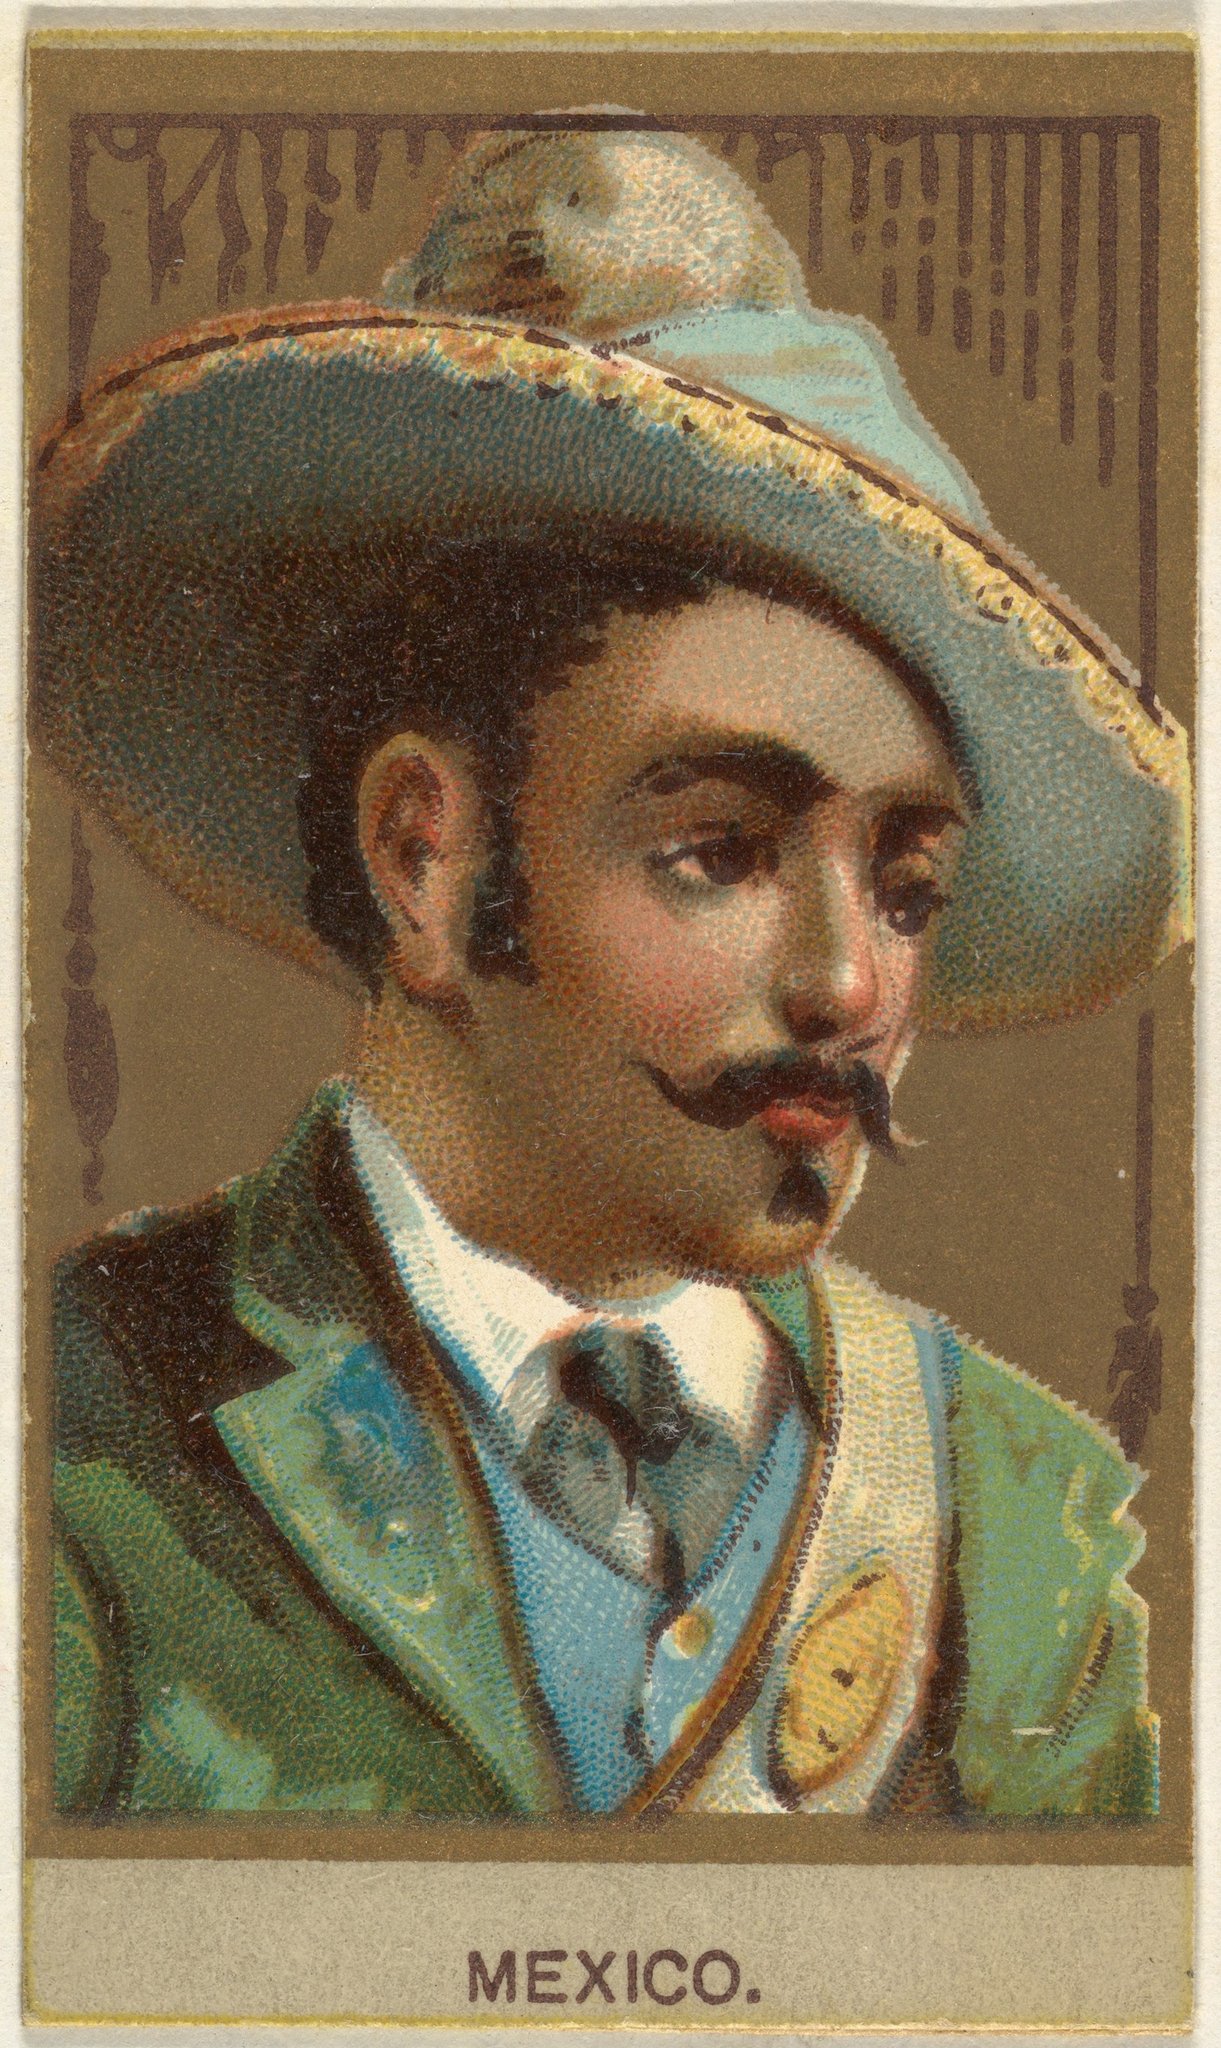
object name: print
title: Mexico, from the Races of Mankind series (T181) issued by Abdul Cigarettes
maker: abdul cigarettes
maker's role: publisher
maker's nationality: american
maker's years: 1881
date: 1881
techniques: color lithograph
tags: men